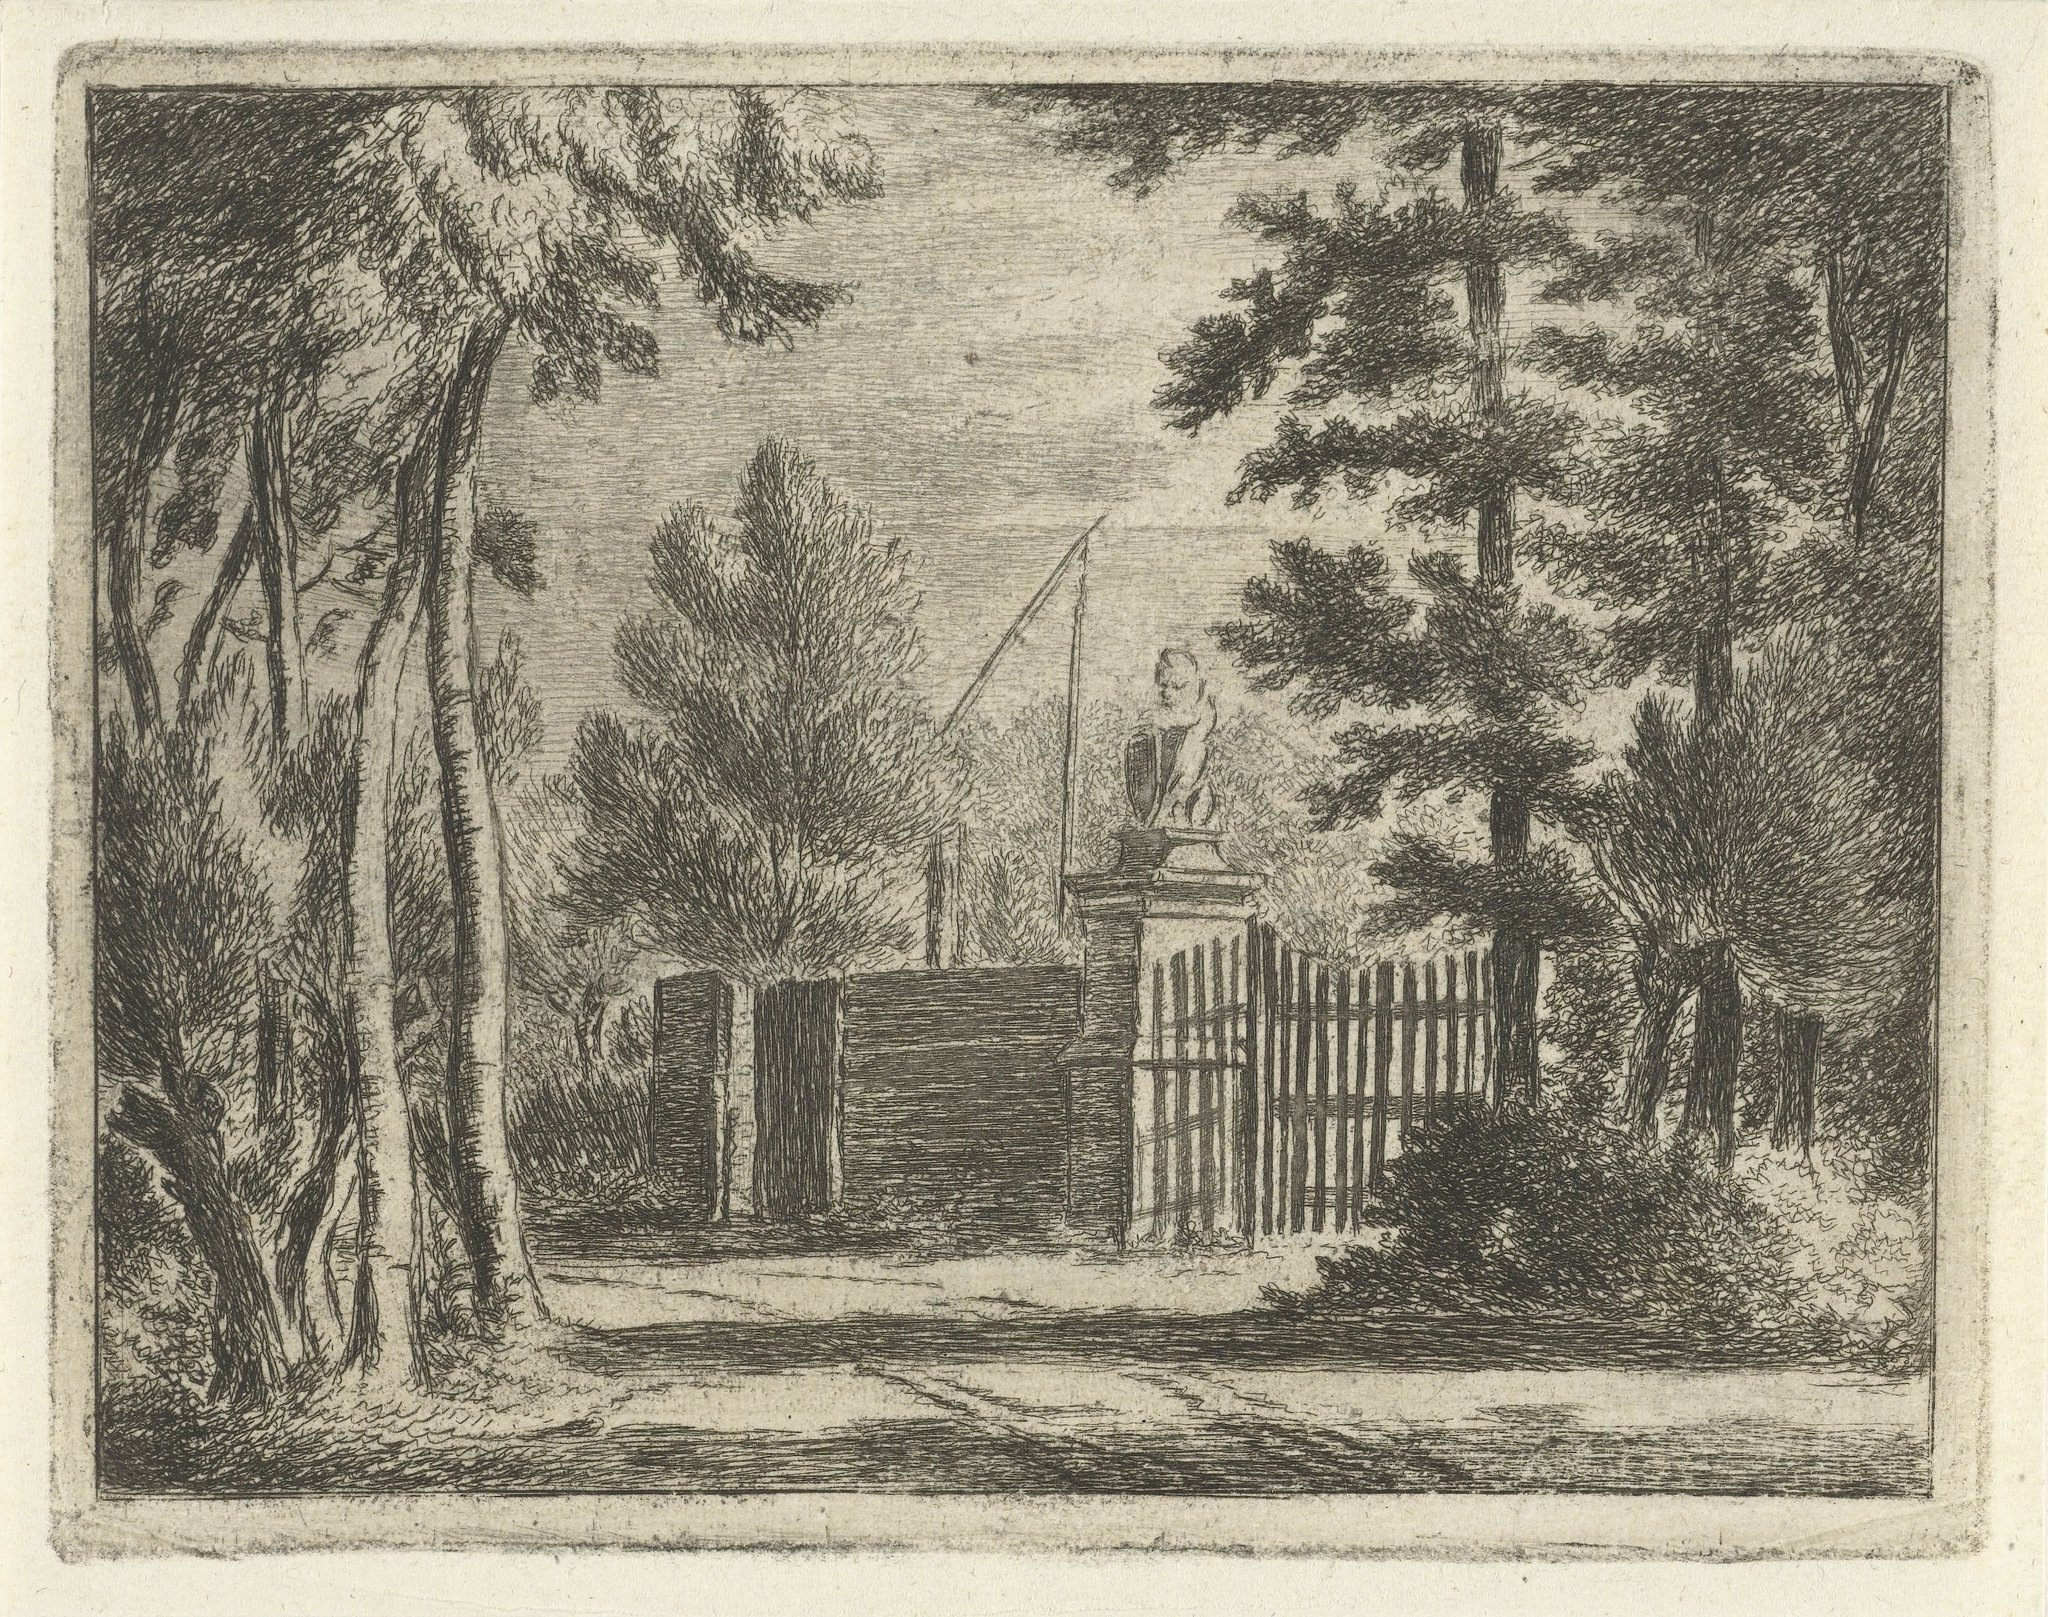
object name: print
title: Poort van een buitenplaats met leeuwenbeeld op een kolom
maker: jacobus cornelis gaal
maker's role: print maker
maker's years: 1796-1866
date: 1854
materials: paper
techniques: etching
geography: netherlands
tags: gate, entrance, village lane, alley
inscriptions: collector's mark: Lugt 2228